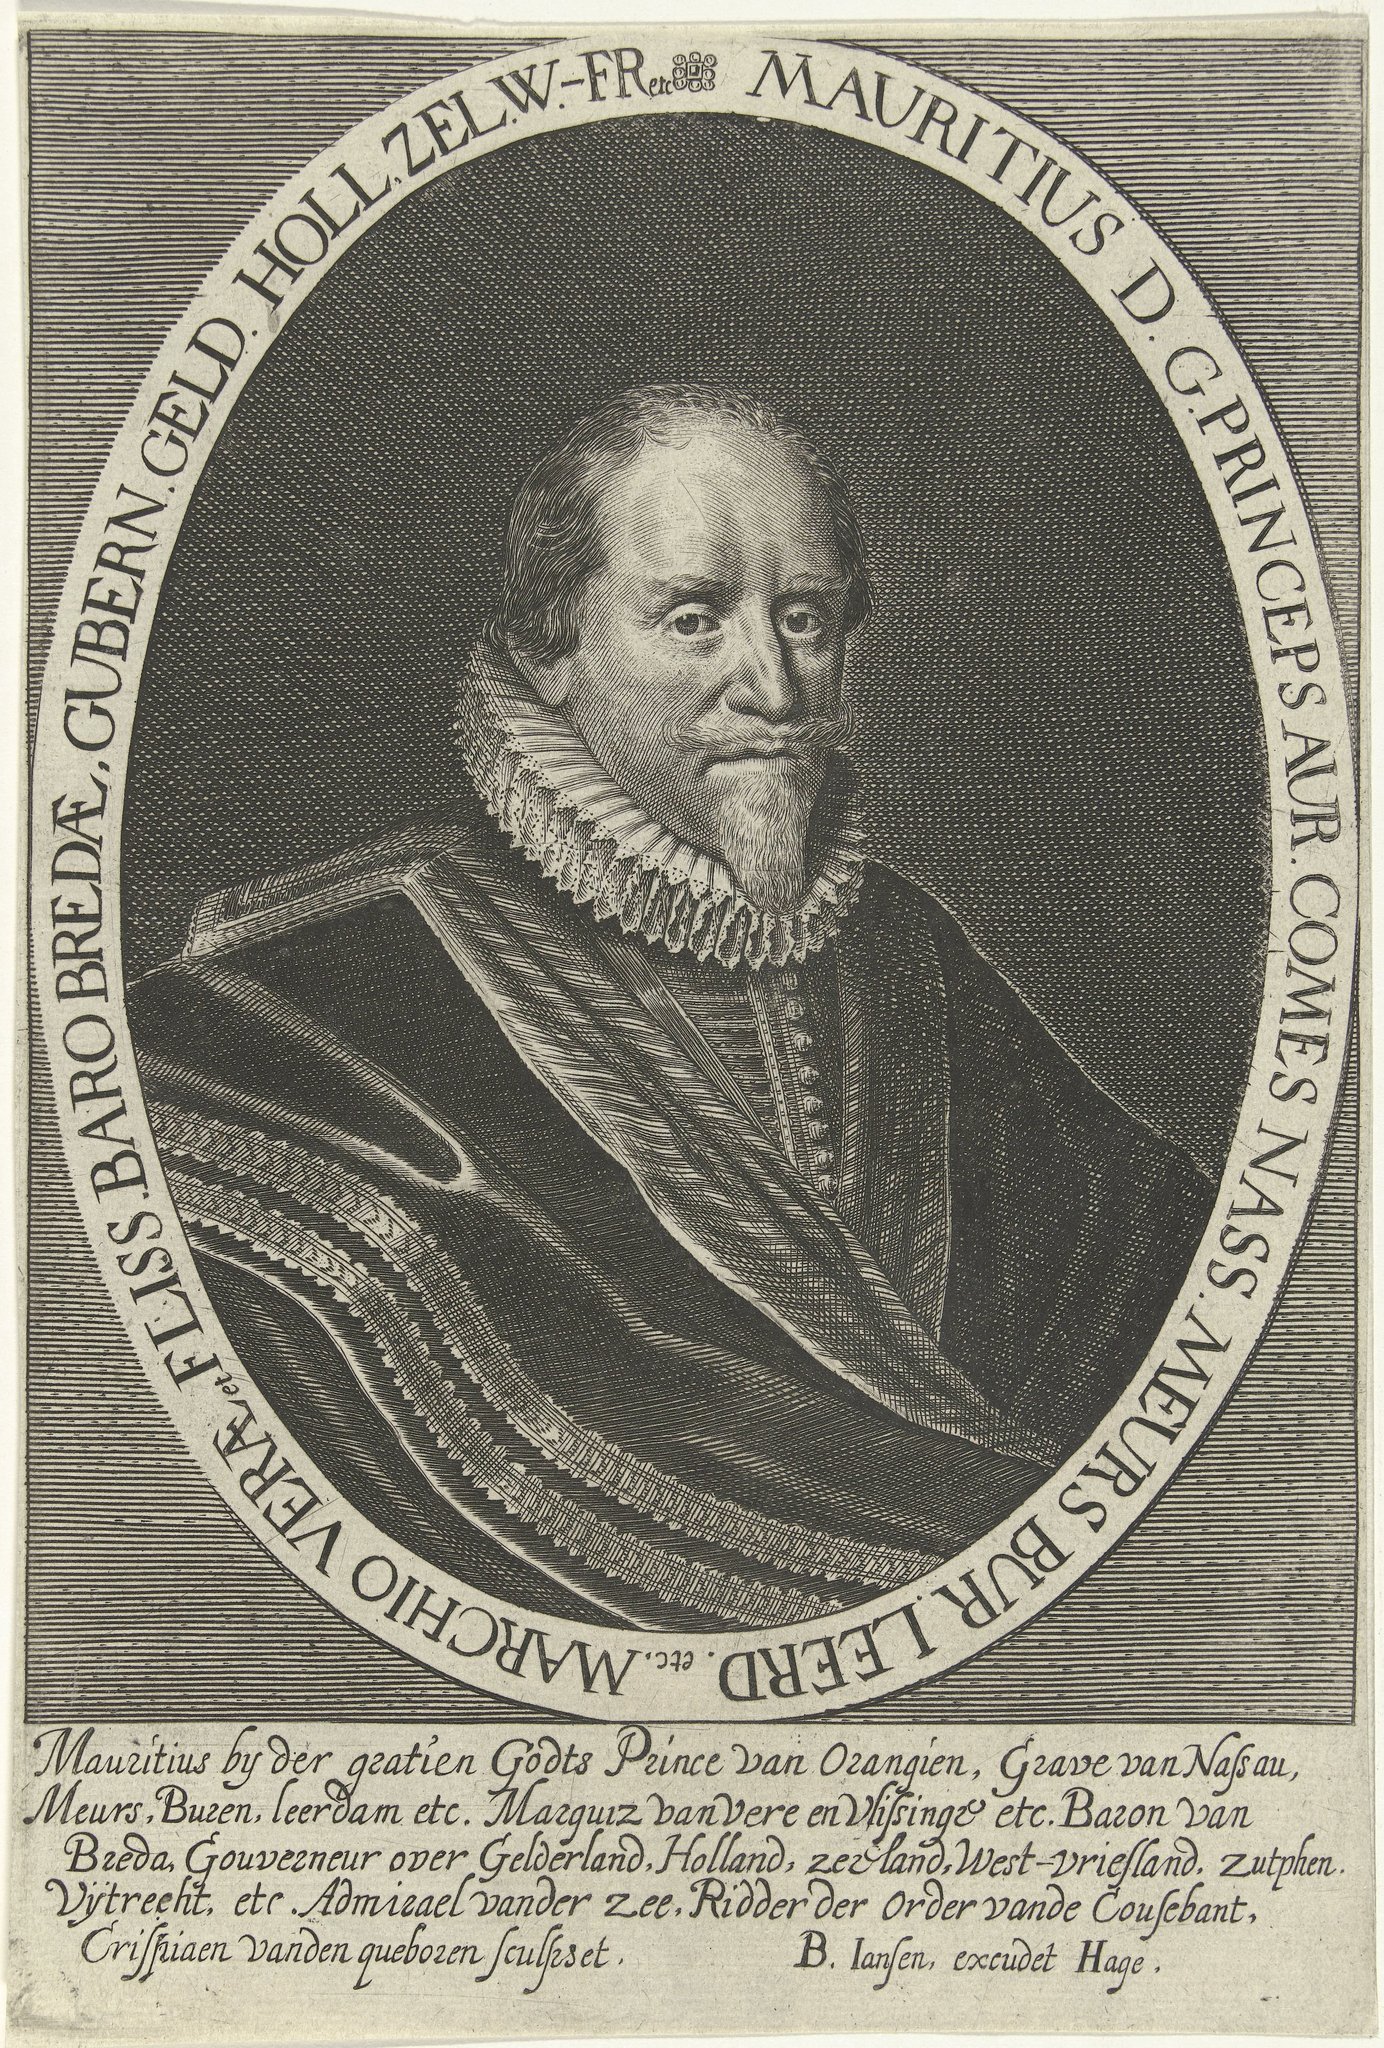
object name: print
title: Portret van prins Maurits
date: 1614-1652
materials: paper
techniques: engraving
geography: the hague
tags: the hague, maurice (prince of orange)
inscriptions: collector's mark: Lugt 2228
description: Portret van Maurits (1567-1625), prins van Oranje. In de marge zijn naam en titels.